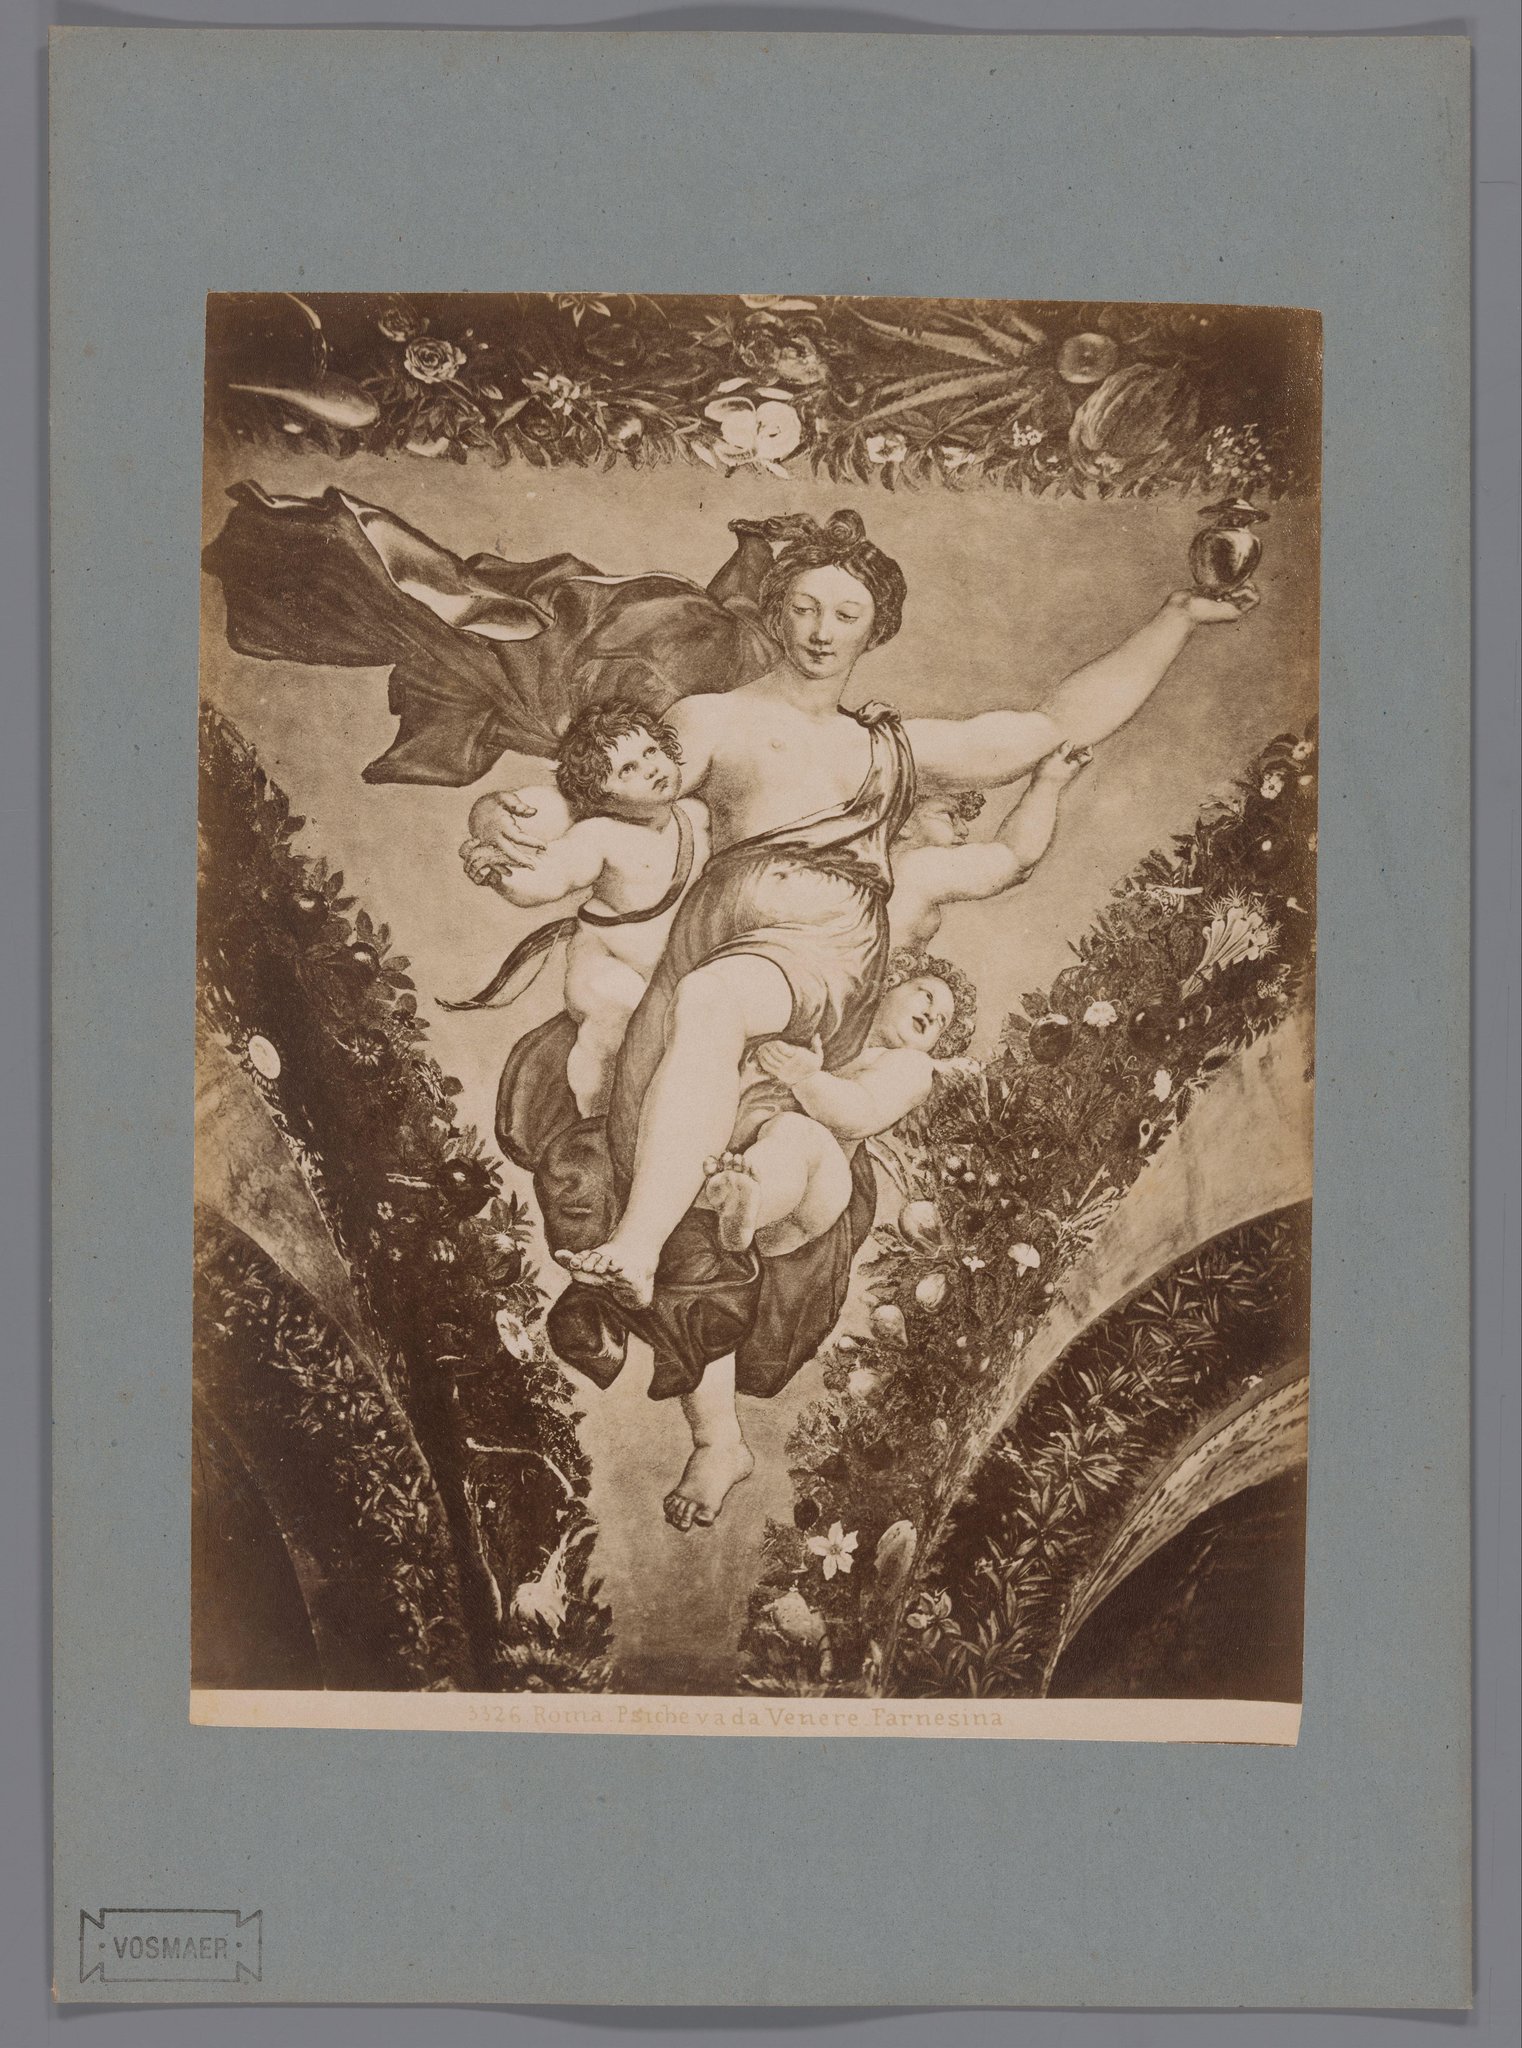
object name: photograph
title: Roma. Psiche va da Venere. Farnesina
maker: Anonymous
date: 1851-1900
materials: cardboard, paper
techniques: albumen print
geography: rome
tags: picture, painting, rome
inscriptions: number: ‘3326.’, collector's mark: ‘VOSMAER’